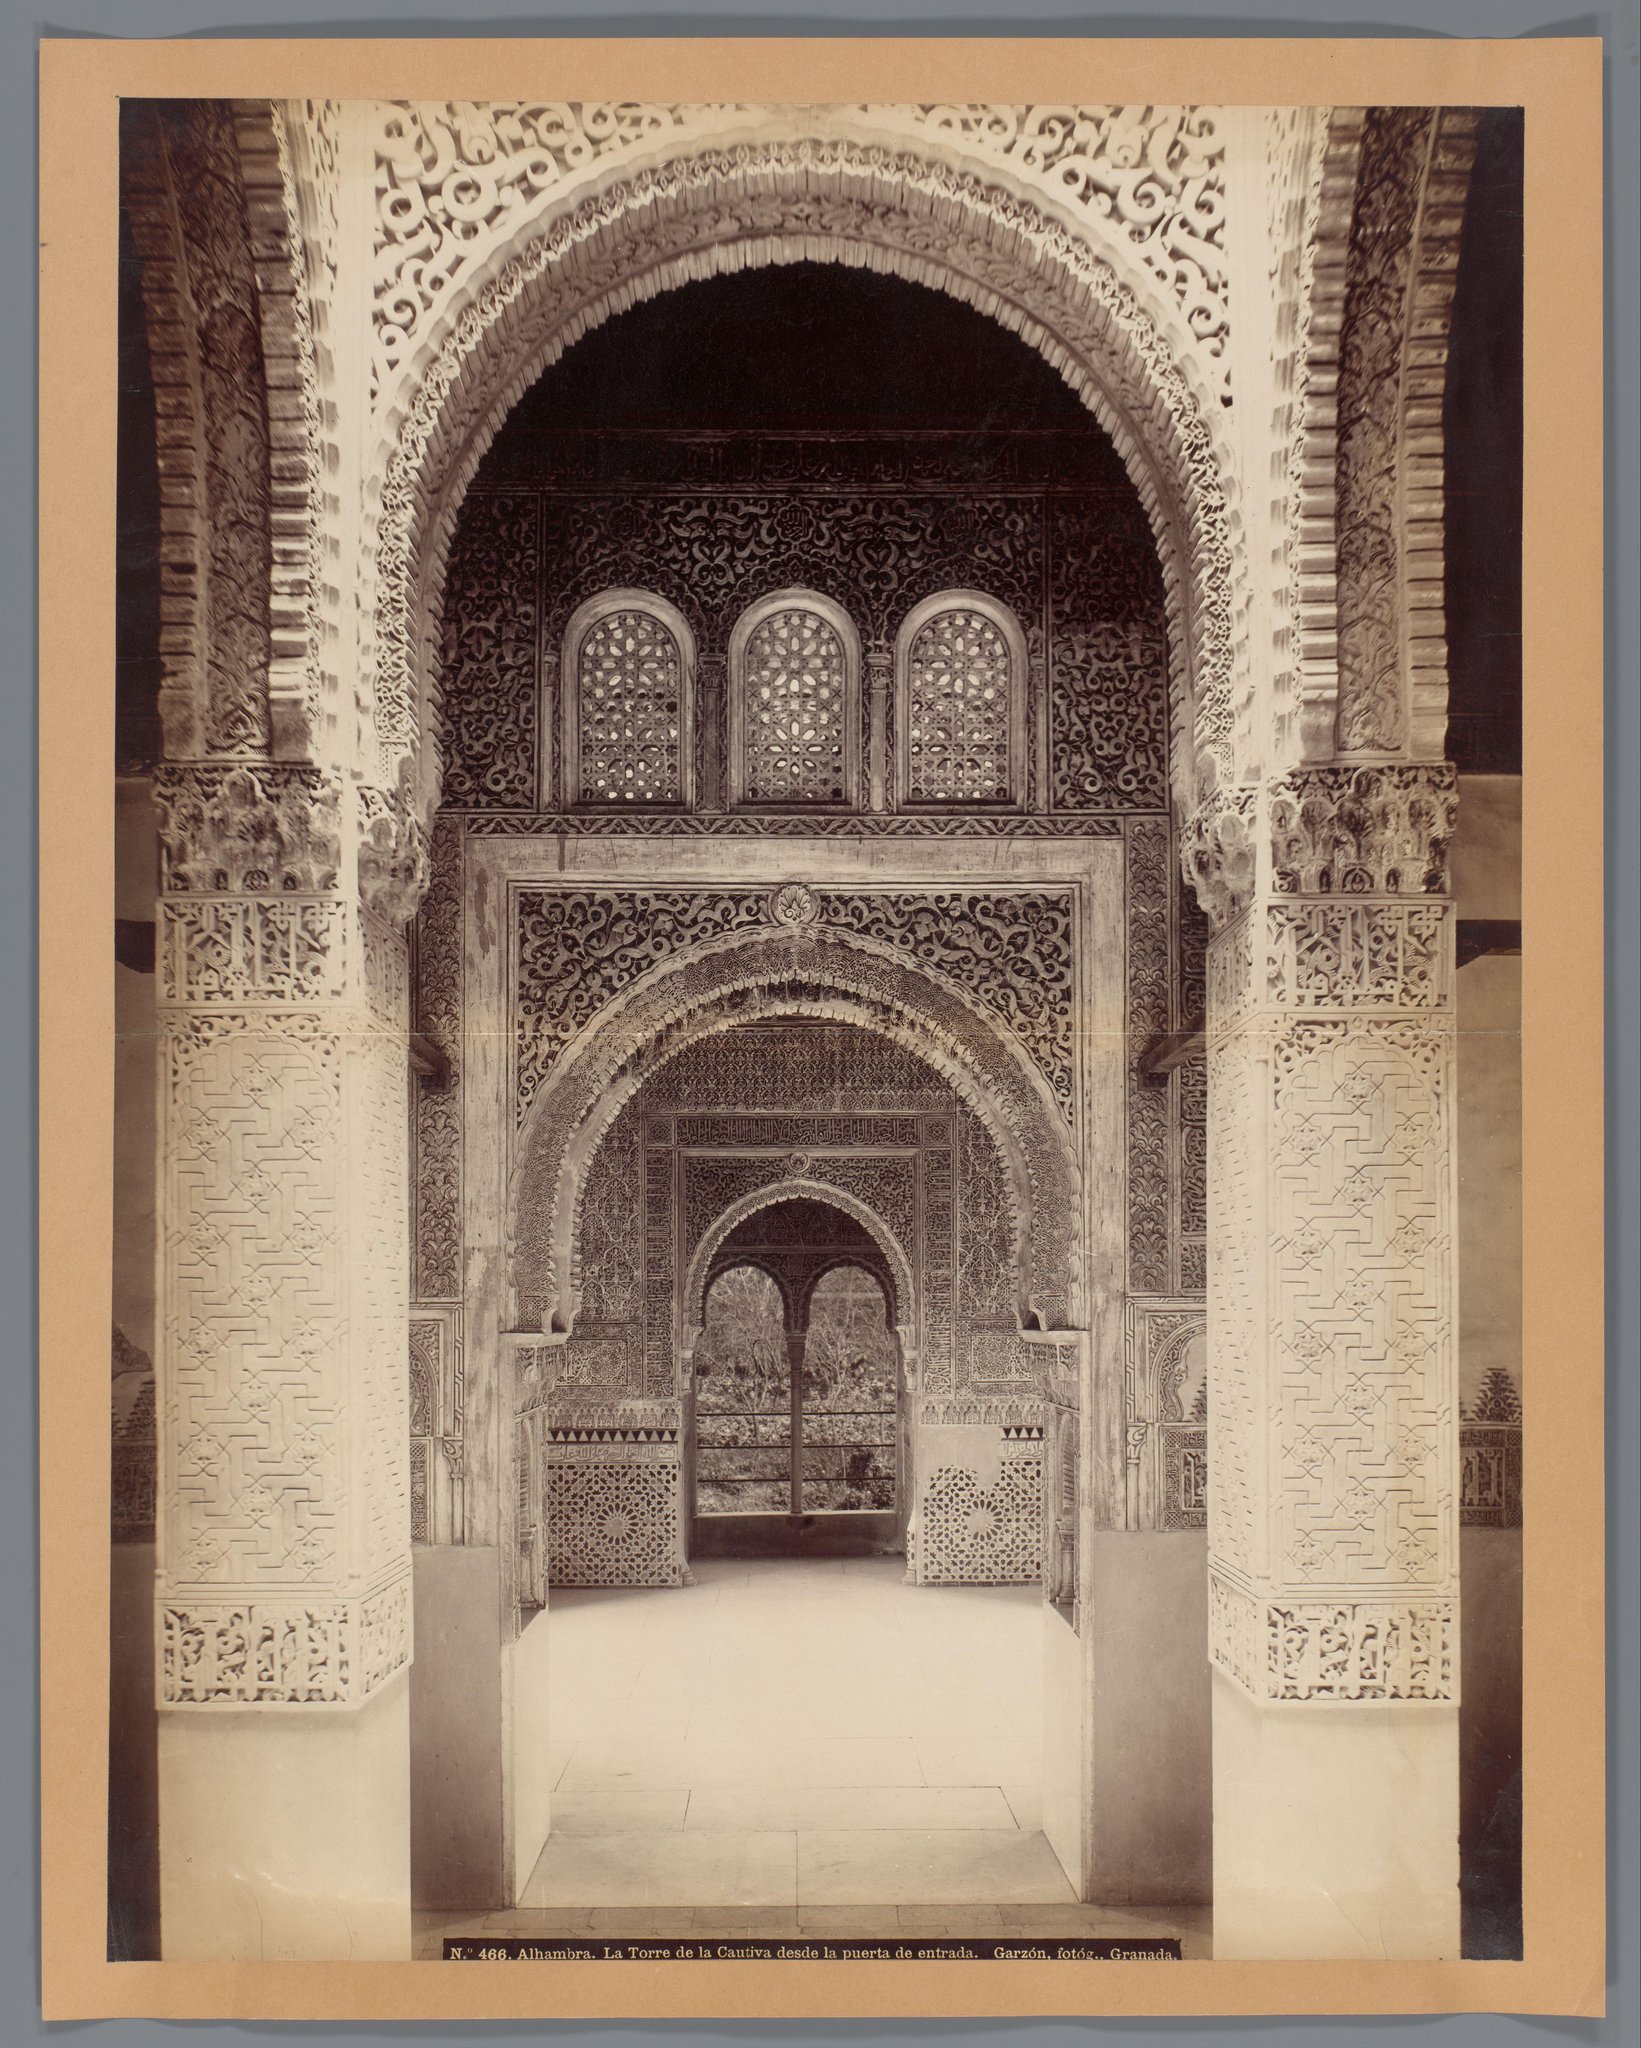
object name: photograph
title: No. 466. Alhambra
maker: rafael garzón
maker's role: publisher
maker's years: 1863-1923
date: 1870-1895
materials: cardboard, paper, photographic support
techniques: albumen print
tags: palace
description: Alhambra. La Torre de la Cautiva desde la puerta de entrada.